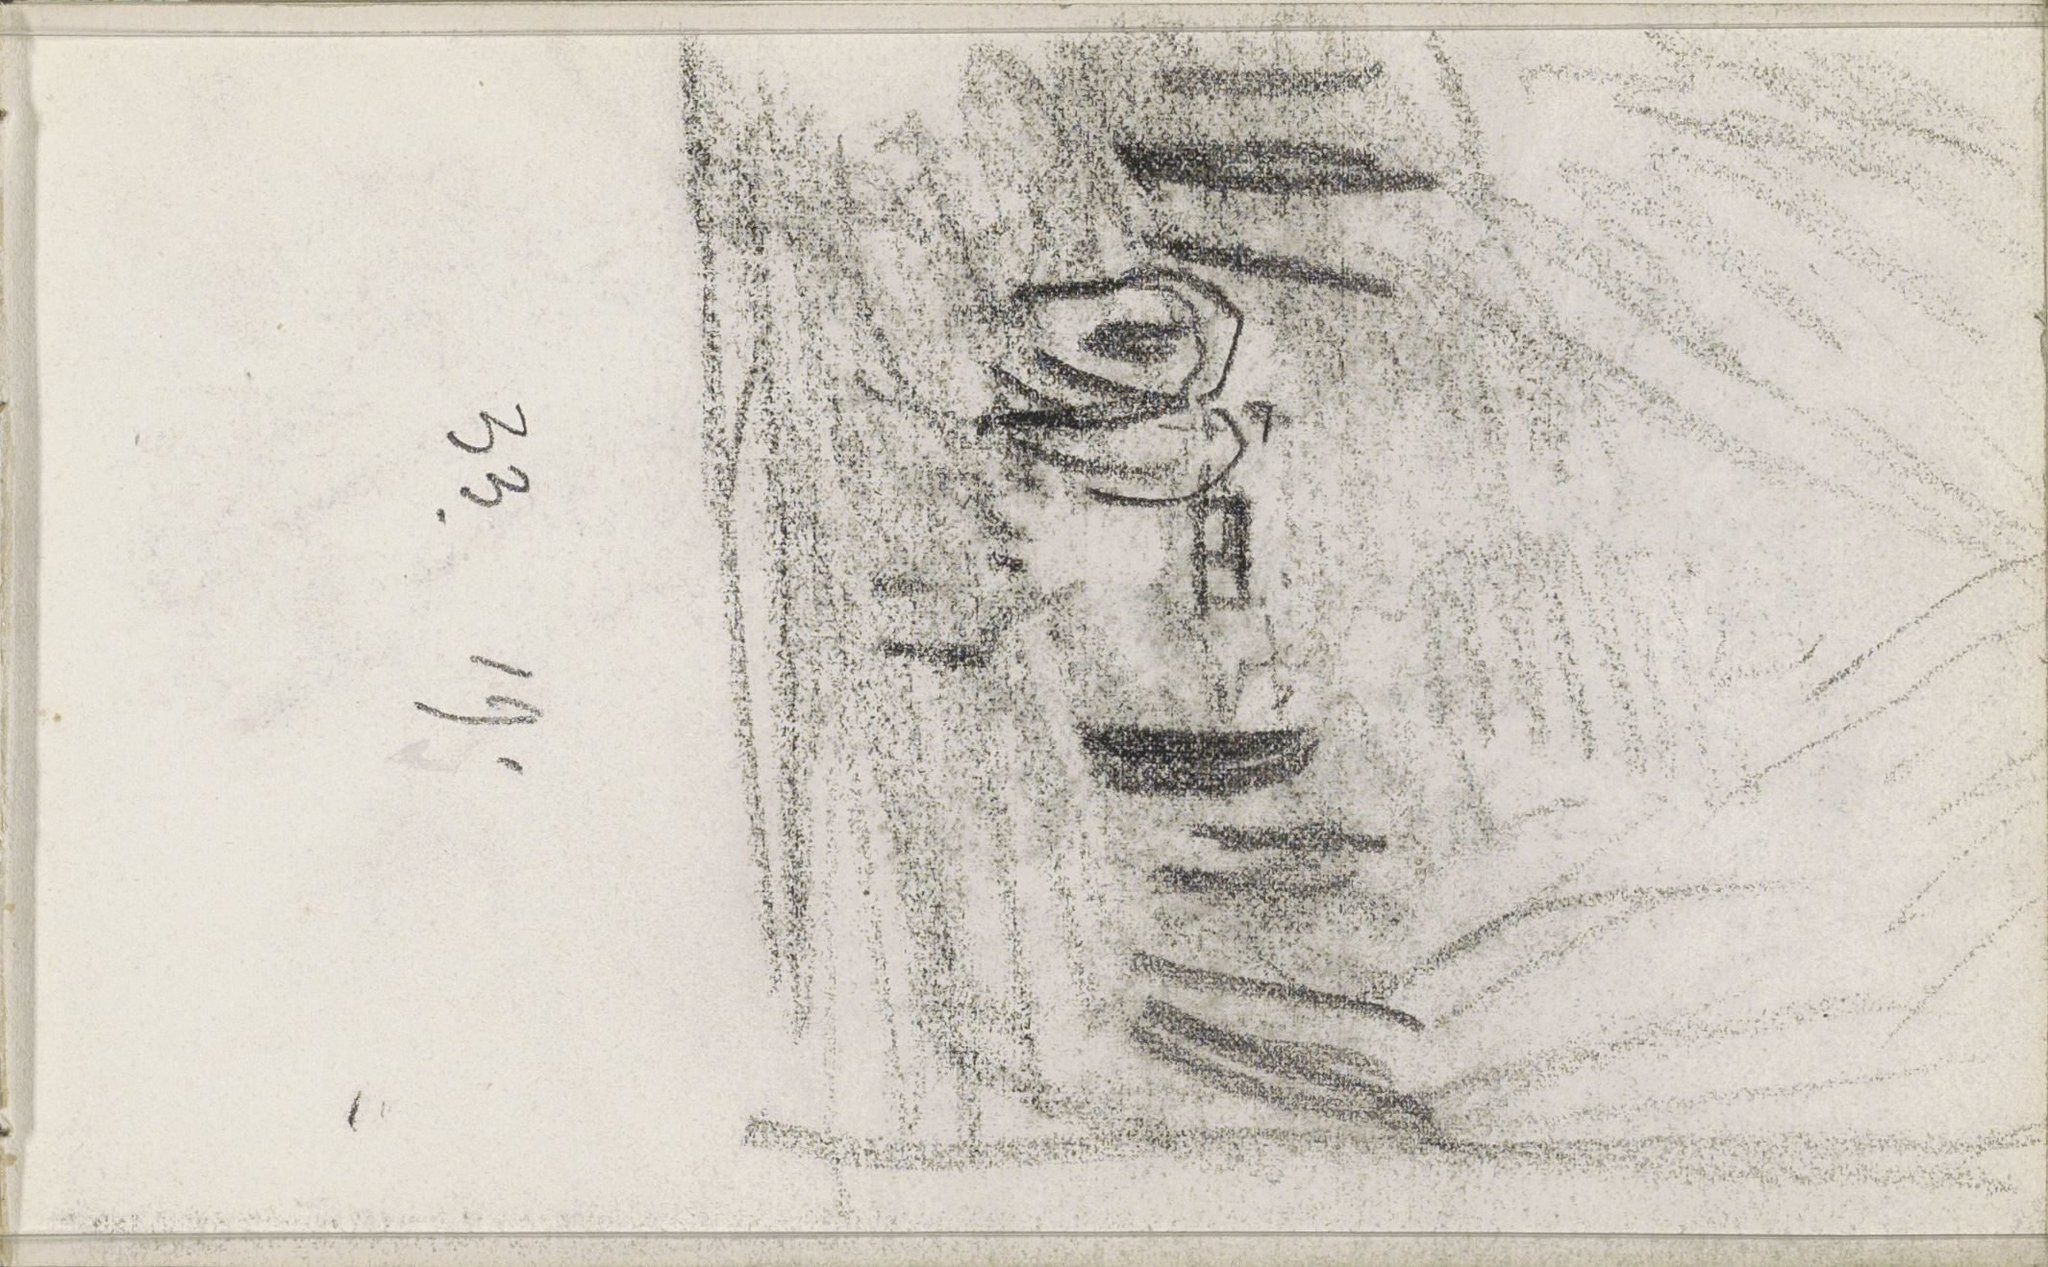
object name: sketchbook leaf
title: Landschap, vermoedelijk met vee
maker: anton mauve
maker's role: draughtsman, painter, print maker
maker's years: 1838-1888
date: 1848-1888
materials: chalk, paper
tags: landscapes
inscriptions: annotation: ‘33. 19.’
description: Blad 25 recto uit een schetsboek met 43 bladen.